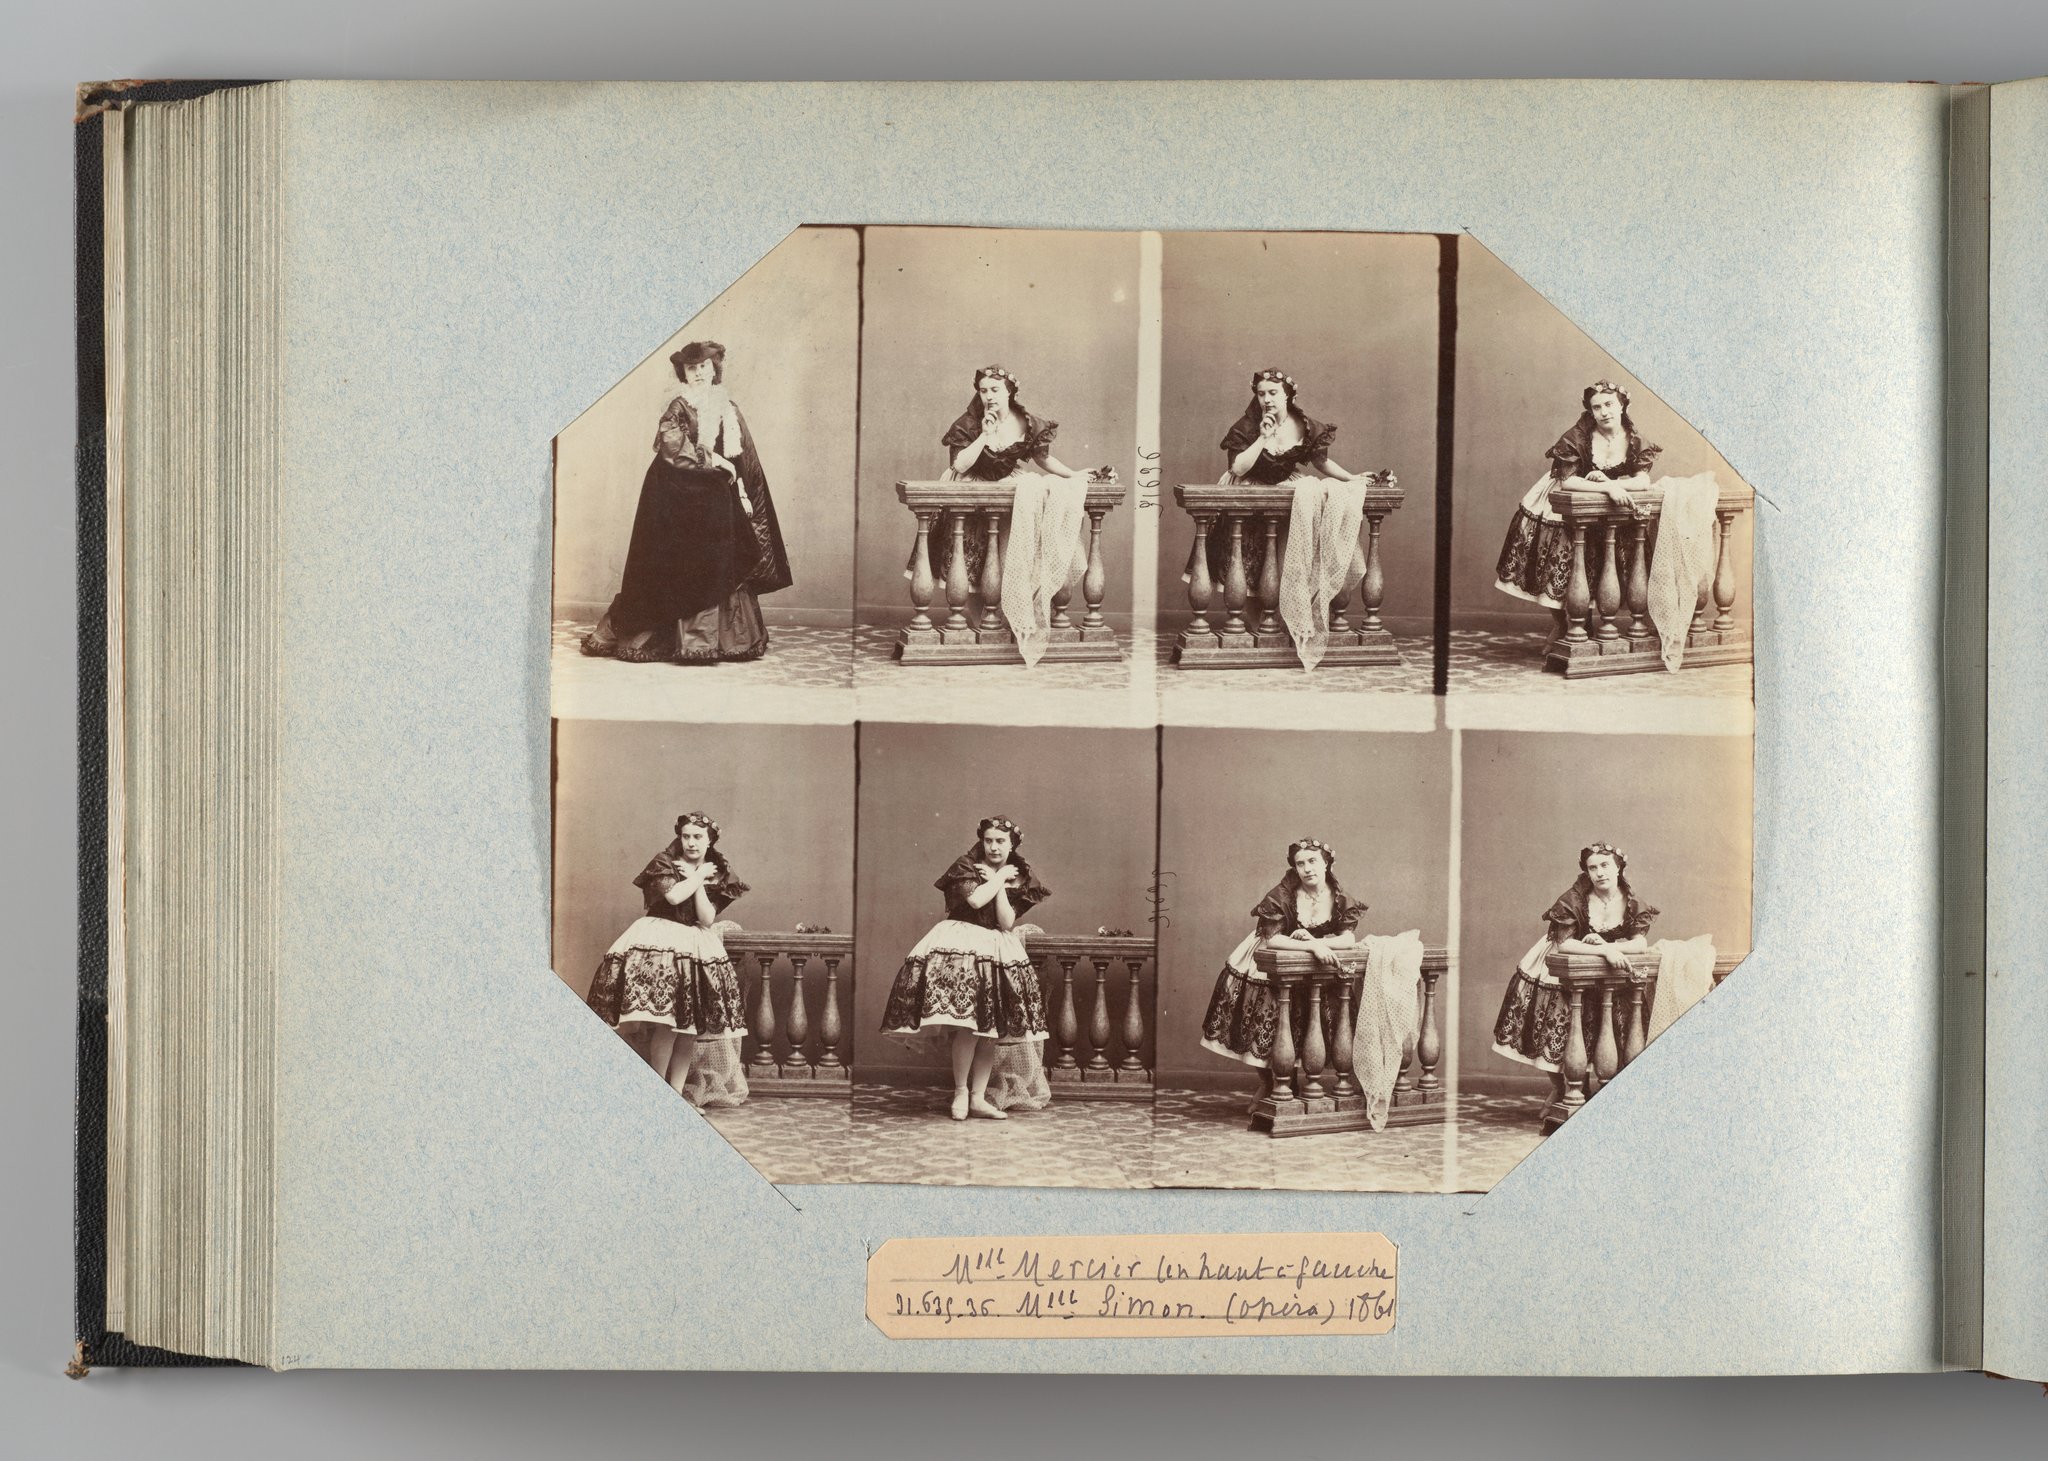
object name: photograph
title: Mlle Mercier; Mlle Simon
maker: andré-adolphe-eugène disdéri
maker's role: artist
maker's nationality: french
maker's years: 1819-1889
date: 1861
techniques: albumen silver print, glass negative